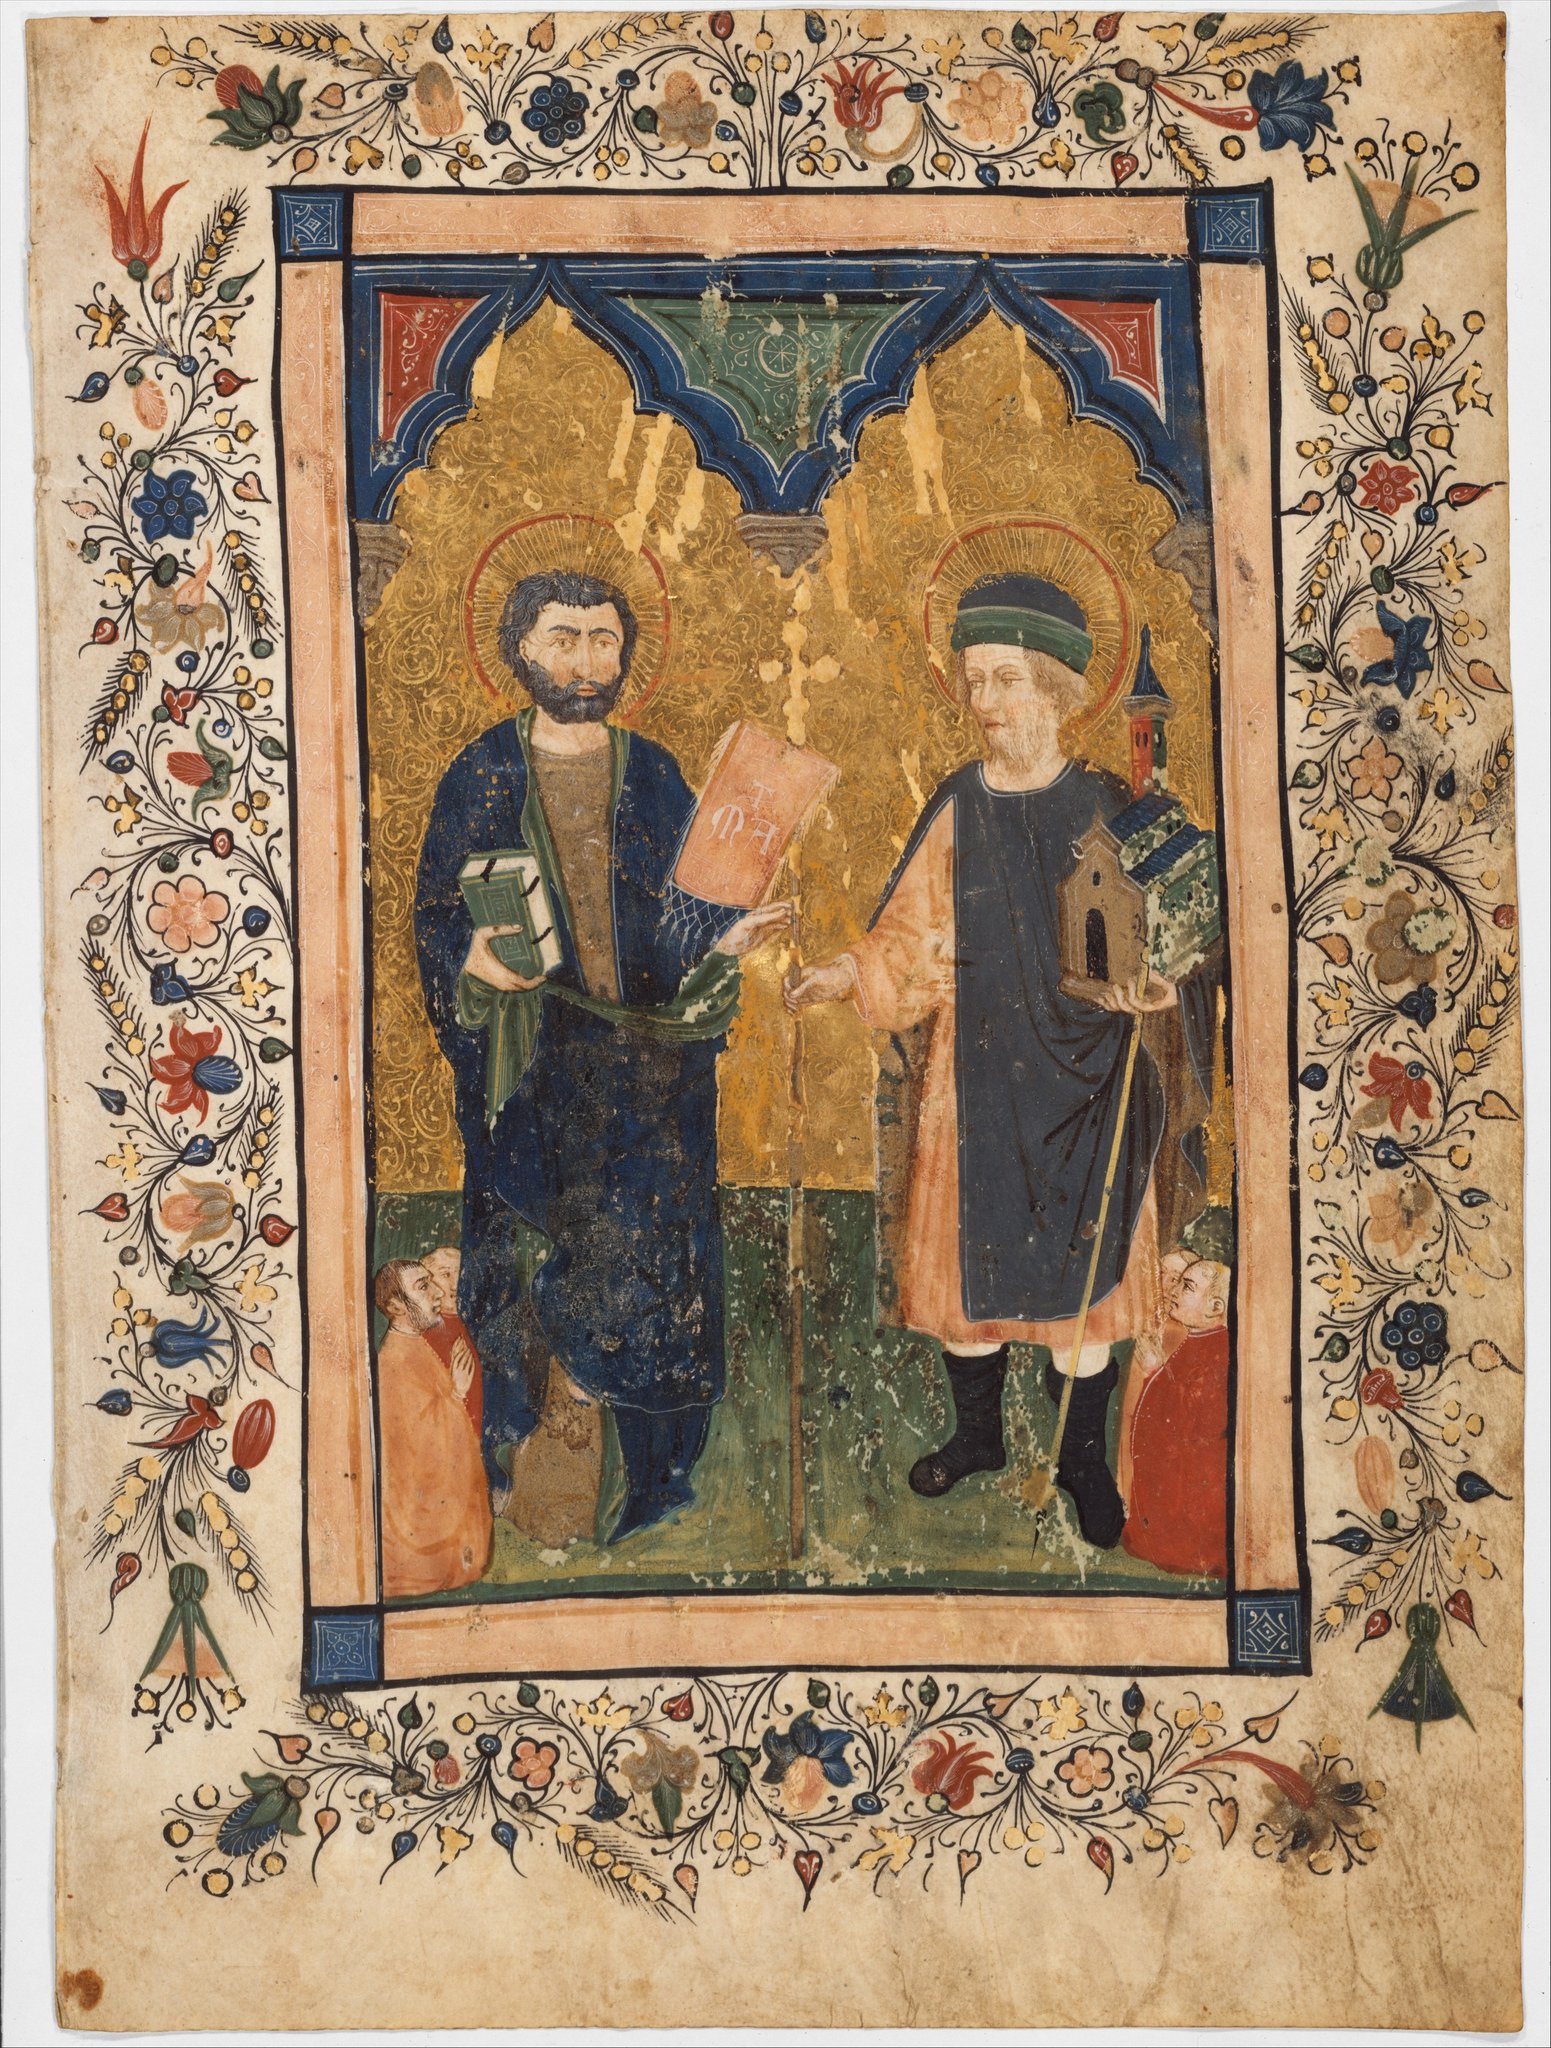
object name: leaf from a mariegola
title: Saint Mark the Evangelist and Saint Sinibaldus Venerated by Members of a Lay Confraternity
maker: cristoforo cortese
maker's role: artist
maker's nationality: italian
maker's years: 1385-1445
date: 1425-1434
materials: gold, parchment, paint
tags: men,saint mark